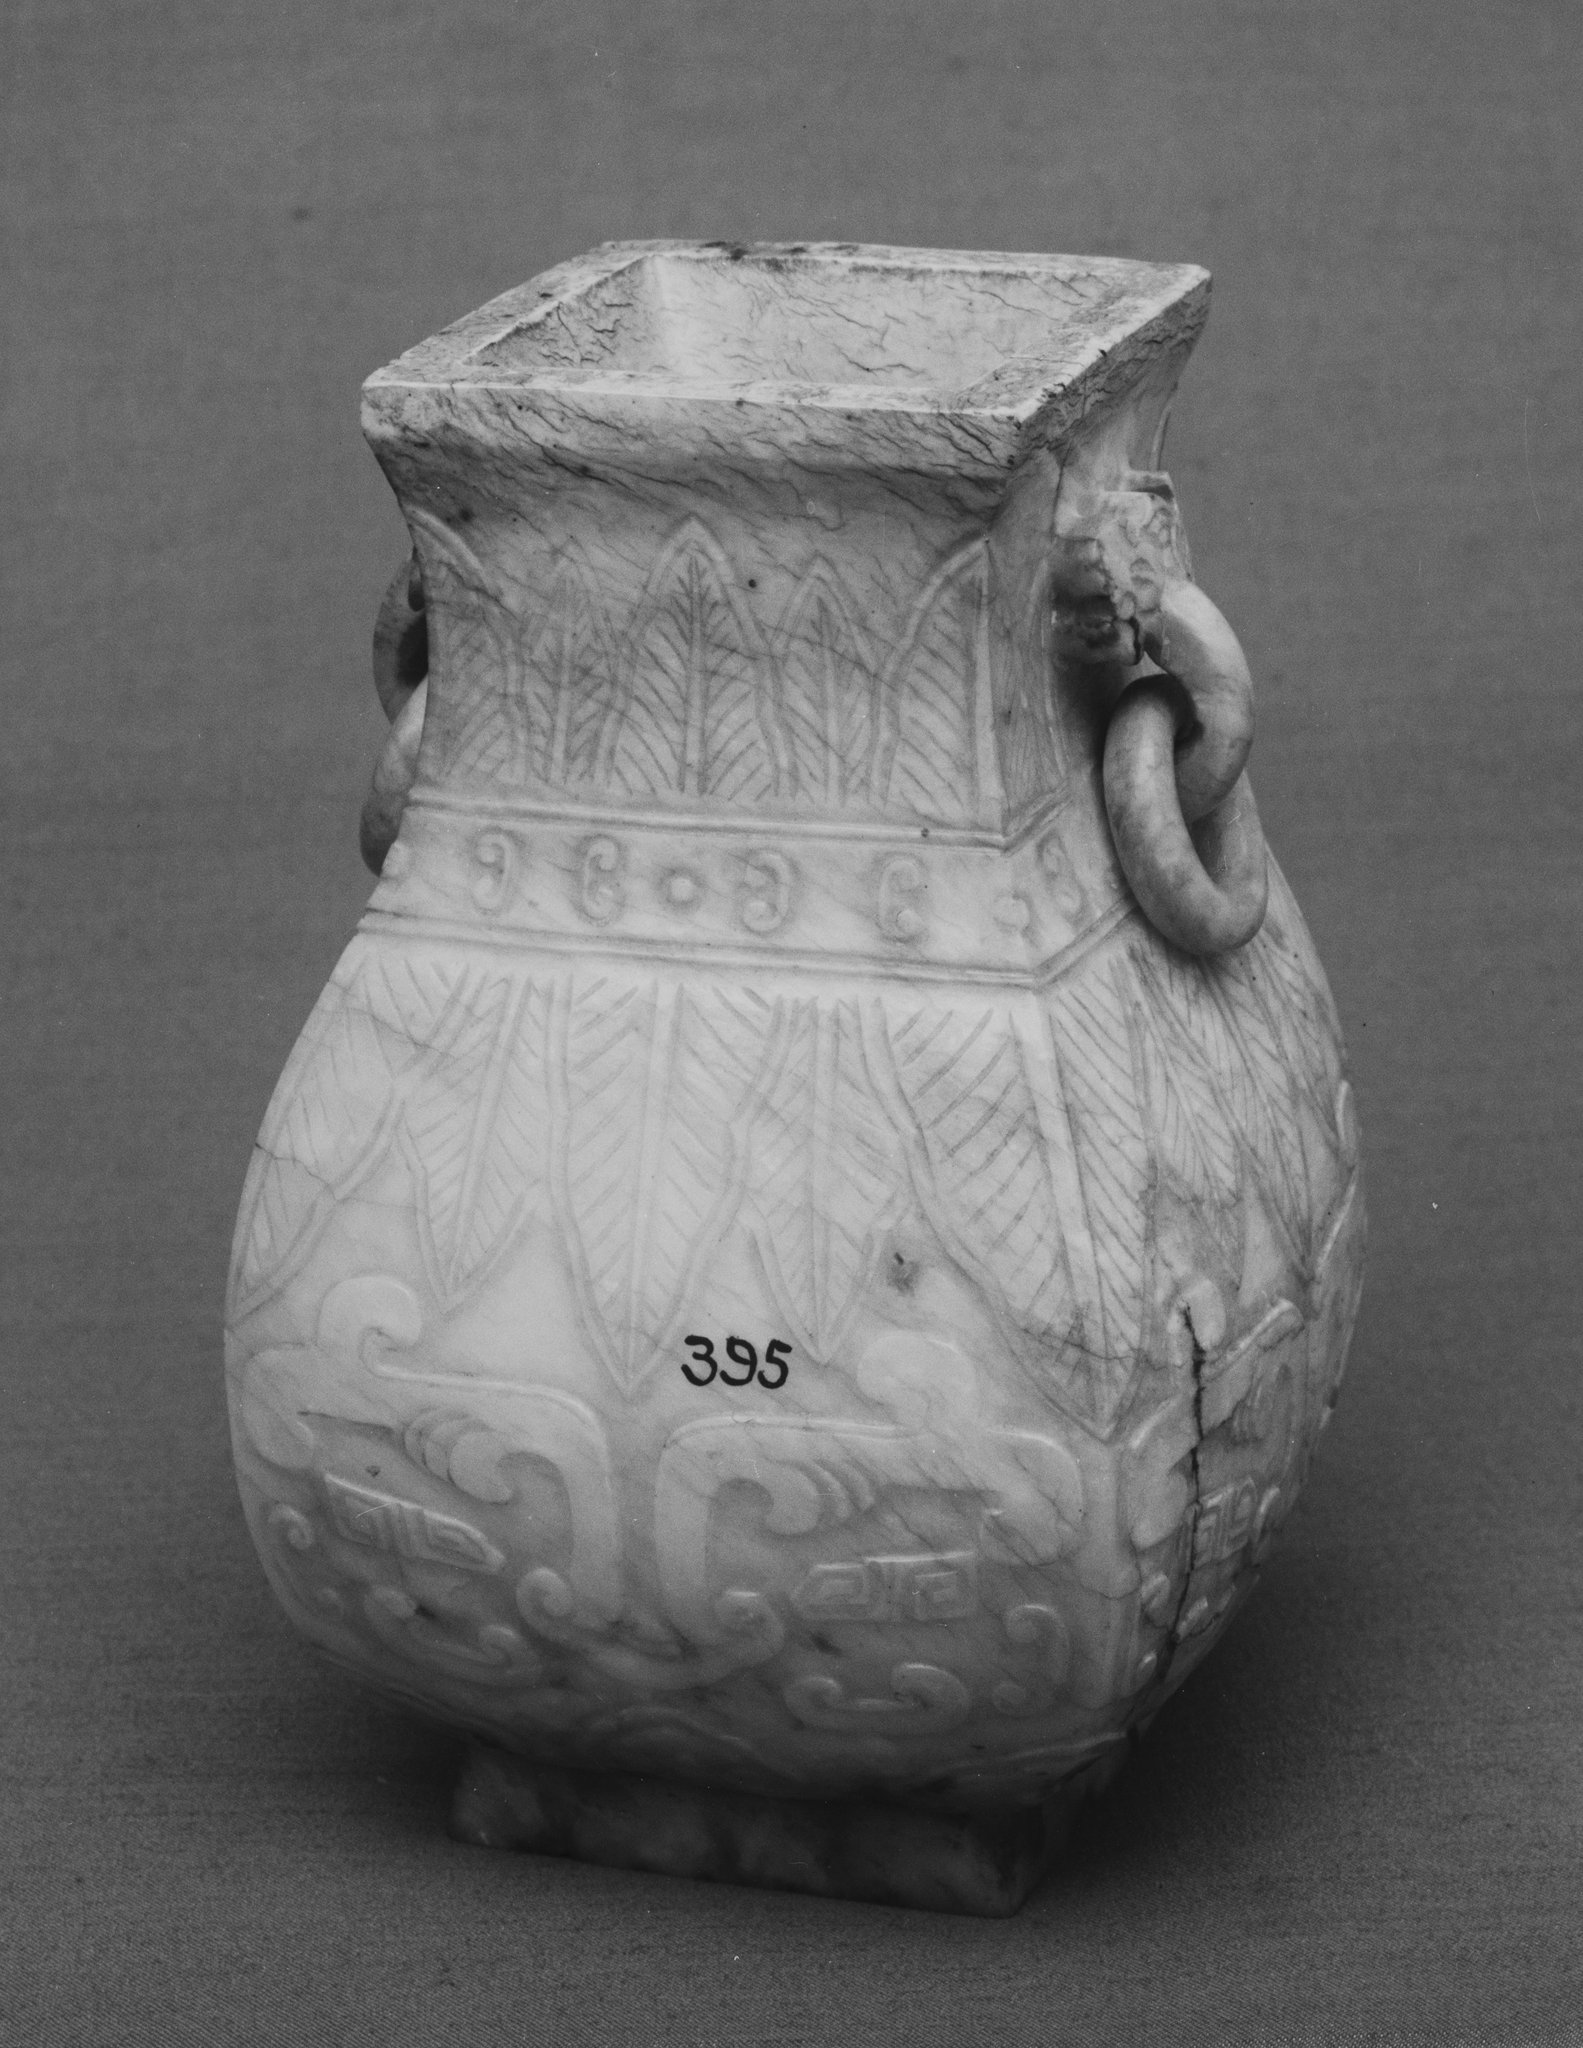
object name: vase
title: Quadrangular Vase (Fang Hu)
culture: chinese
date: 1368-1644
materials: jade